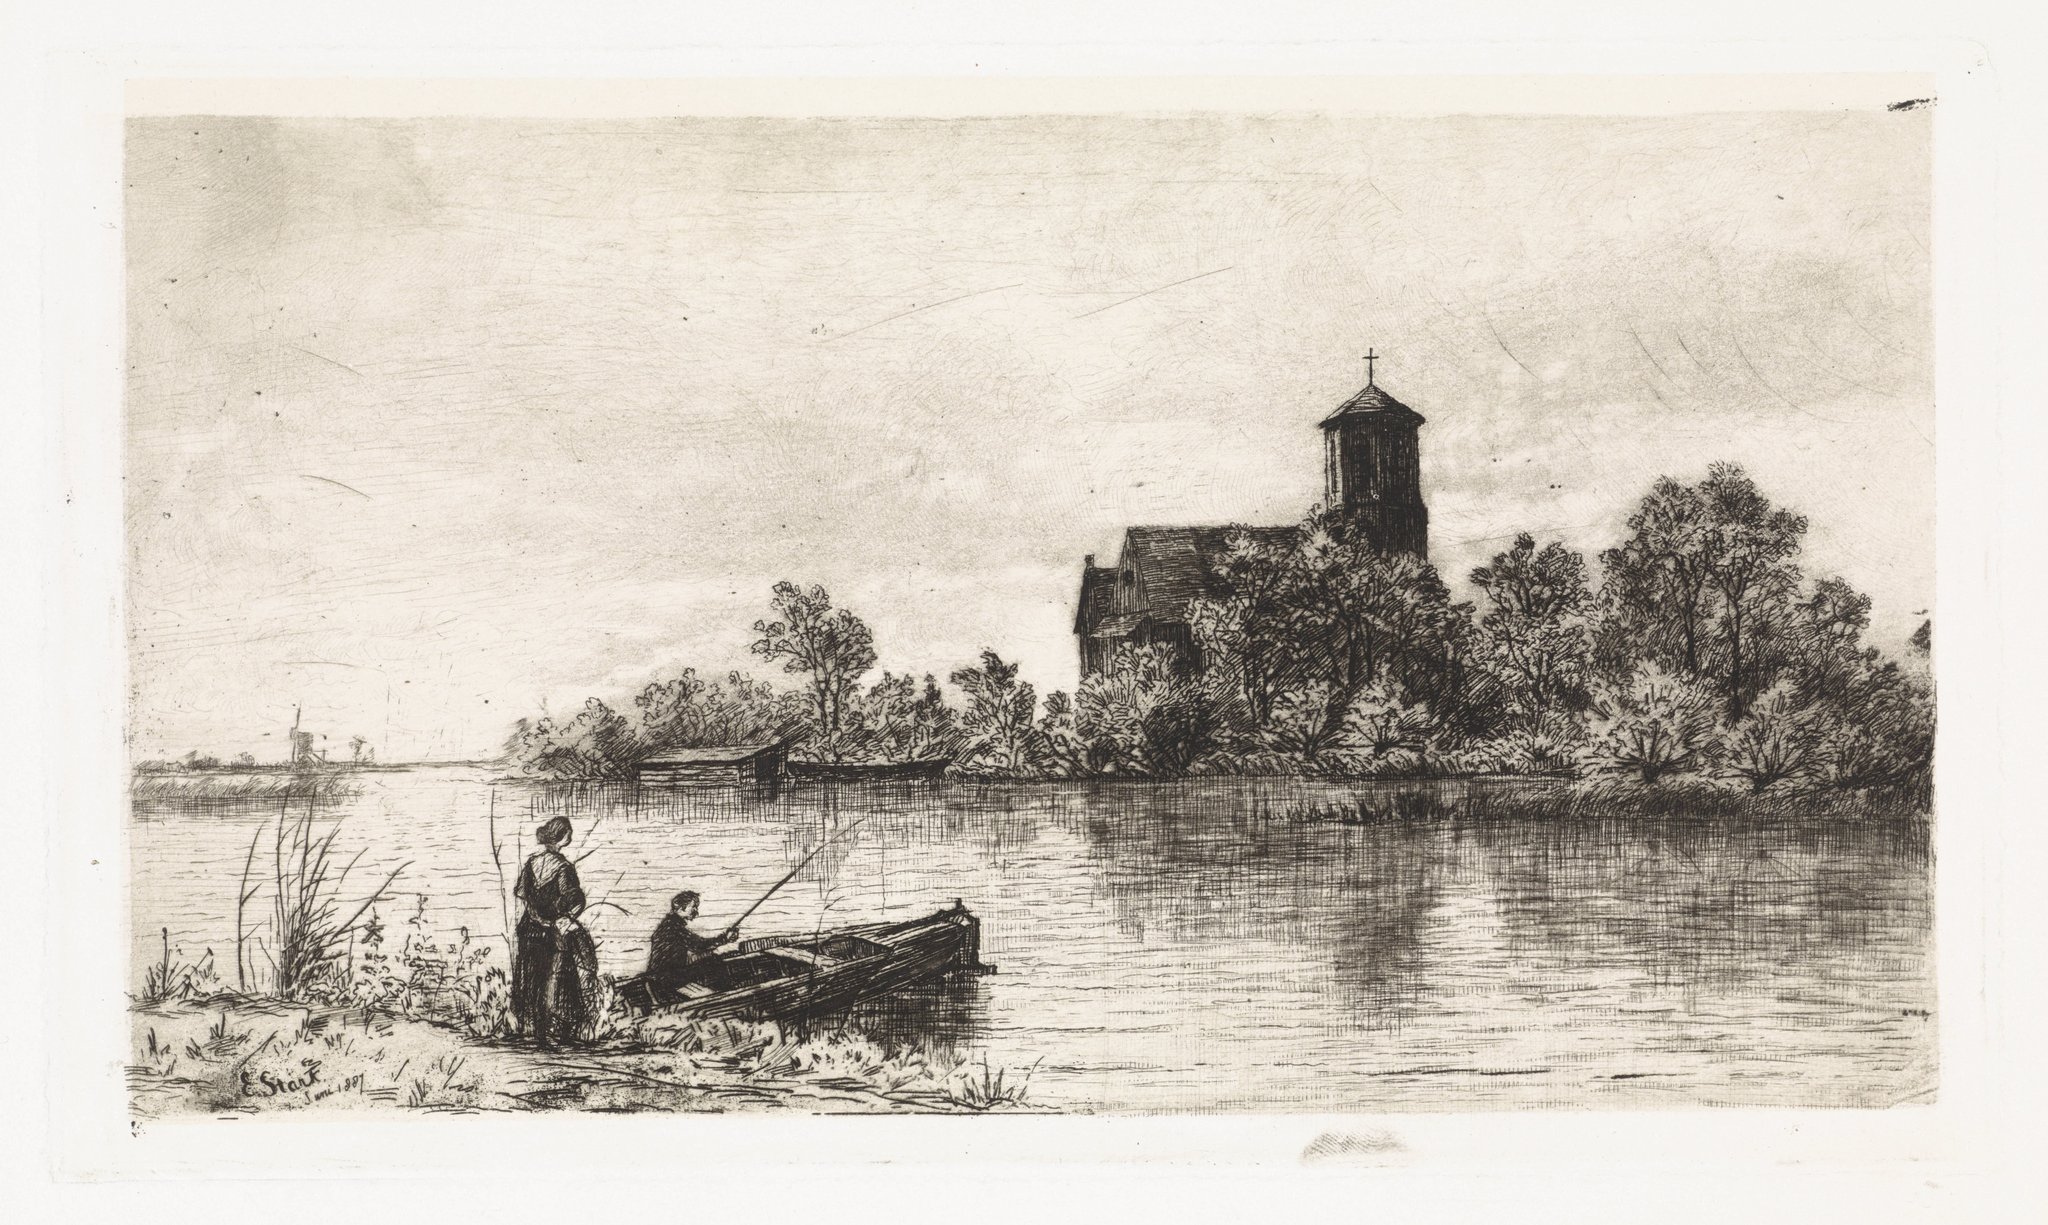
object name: print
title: Gezicht op de Sint Urbanuskerk te Bovenkerk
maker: elias stark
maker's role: draughtsman, print maker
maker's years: 1849-1933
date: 1806-1887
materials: paper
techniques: aquatint, etching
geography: nieuwer-amstel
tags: church (exterior)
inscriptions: collector's mark: Lugt 2228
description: Gezicht op de St. Urbanuskerk te Bovenkerk met op de voorgrond water en een roeiboot. In de roeiboot zit een hengelaar en op de oever staat een vrouw.